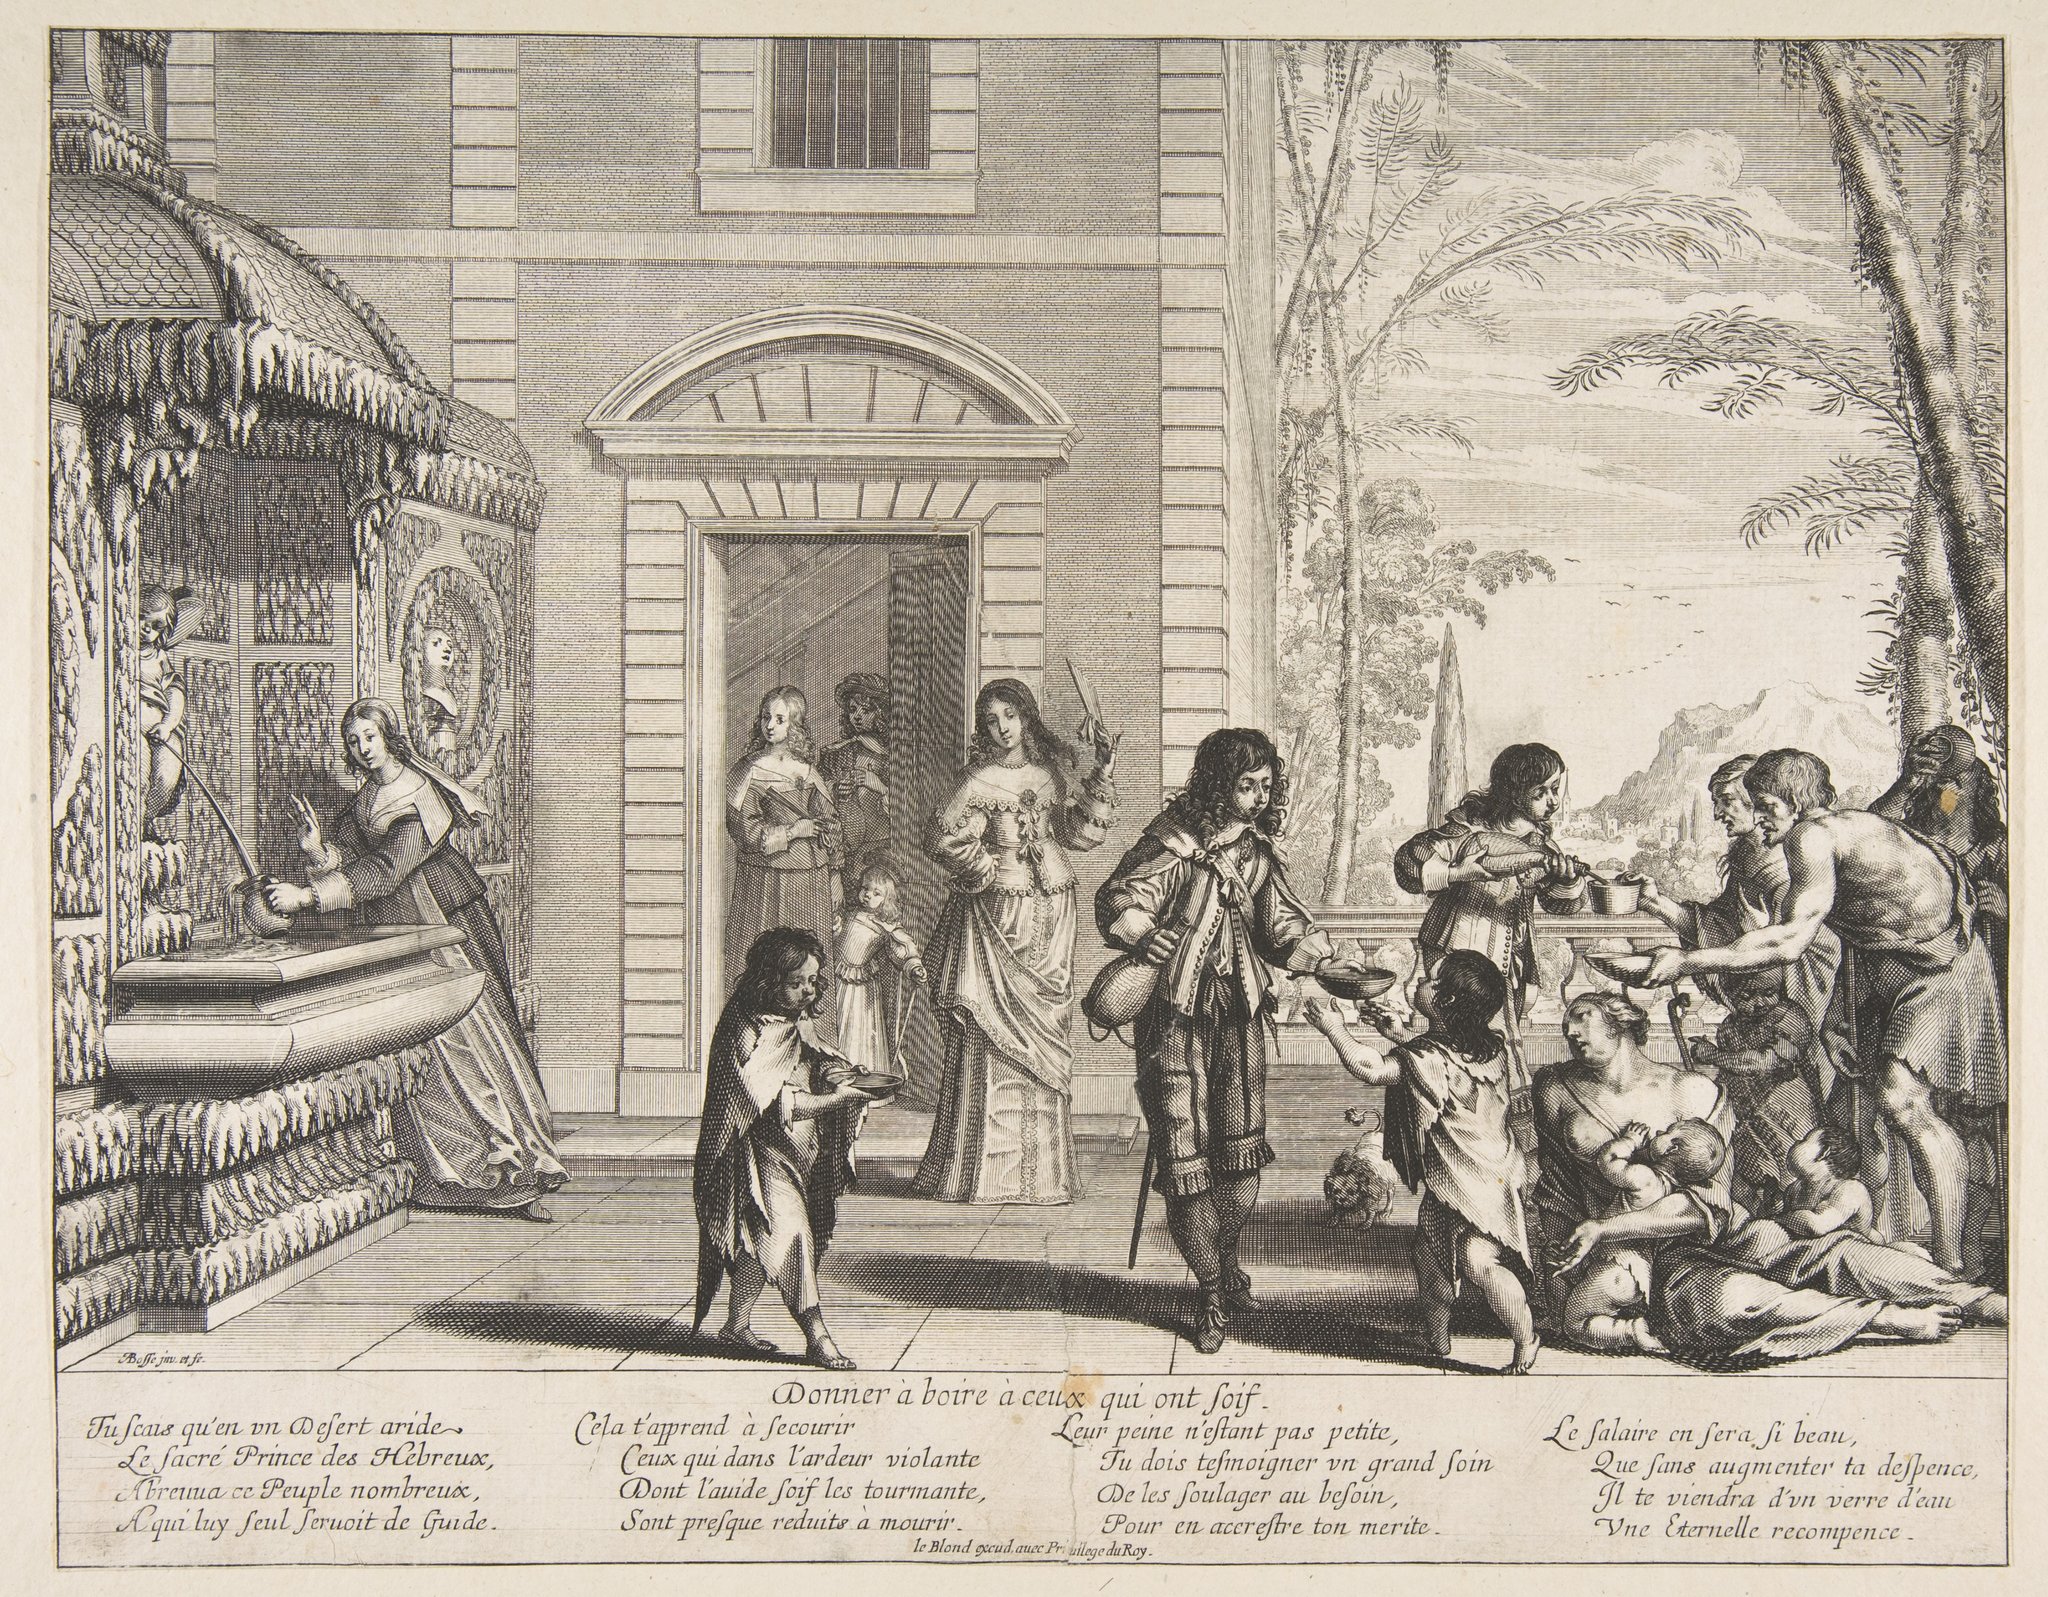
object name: print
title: Giving Drink to the Thirsty (Donner à boire à ceux qui ont soif)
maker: abraham bosse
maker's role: artist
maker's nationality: french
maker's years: 1602-1676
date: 1602-1676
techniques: etching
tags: children,men,women